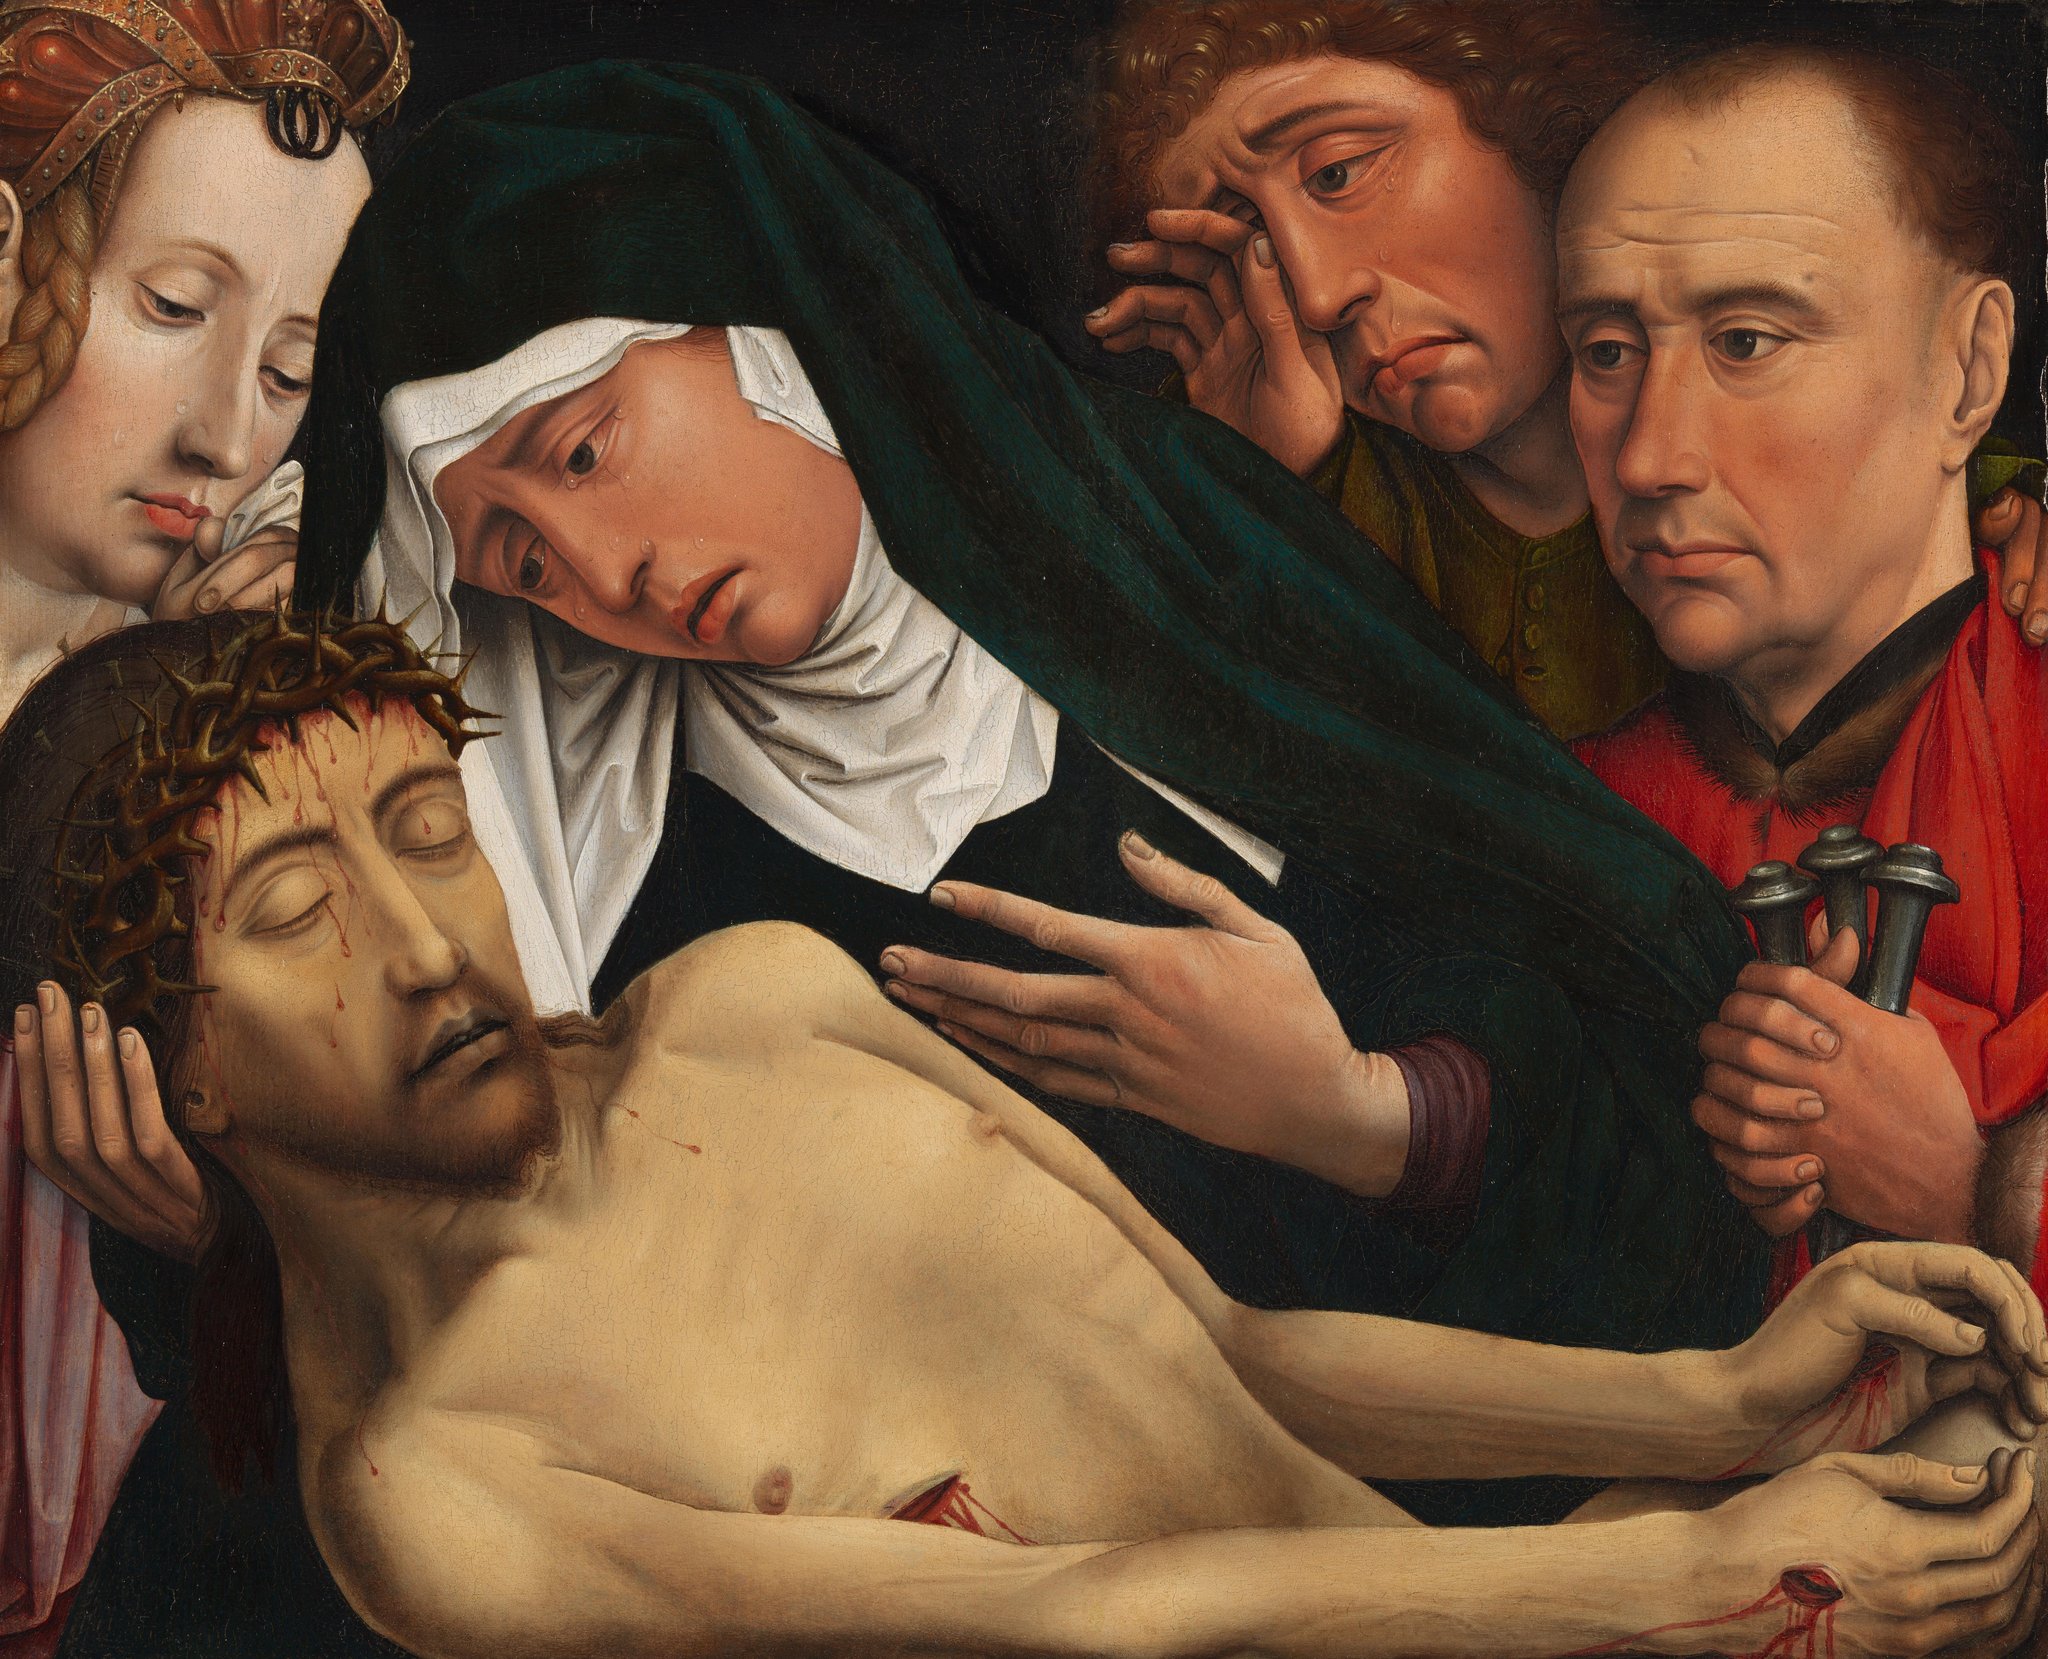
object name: painting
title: The Lamentation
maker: colijn de coter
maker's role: draughtsman, painter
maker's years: 1450-1532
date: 1510-1515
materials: oil, panel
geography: brussels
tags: lamentation over the dead christ by his relatives and friends (christ usually without crown of thorns)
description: Here the artist ‘zoomed in’ on the faces of the dead Christ and his grieving disciples. The painting is thus both intimate and confrontational. This made it easier for believers to identify with Christ’s suffering and the Virgin’s sorrow. The man on the right holding the nails from the cross is Nicodemus; it is probably also a portrait of the person who commissioned the painting.